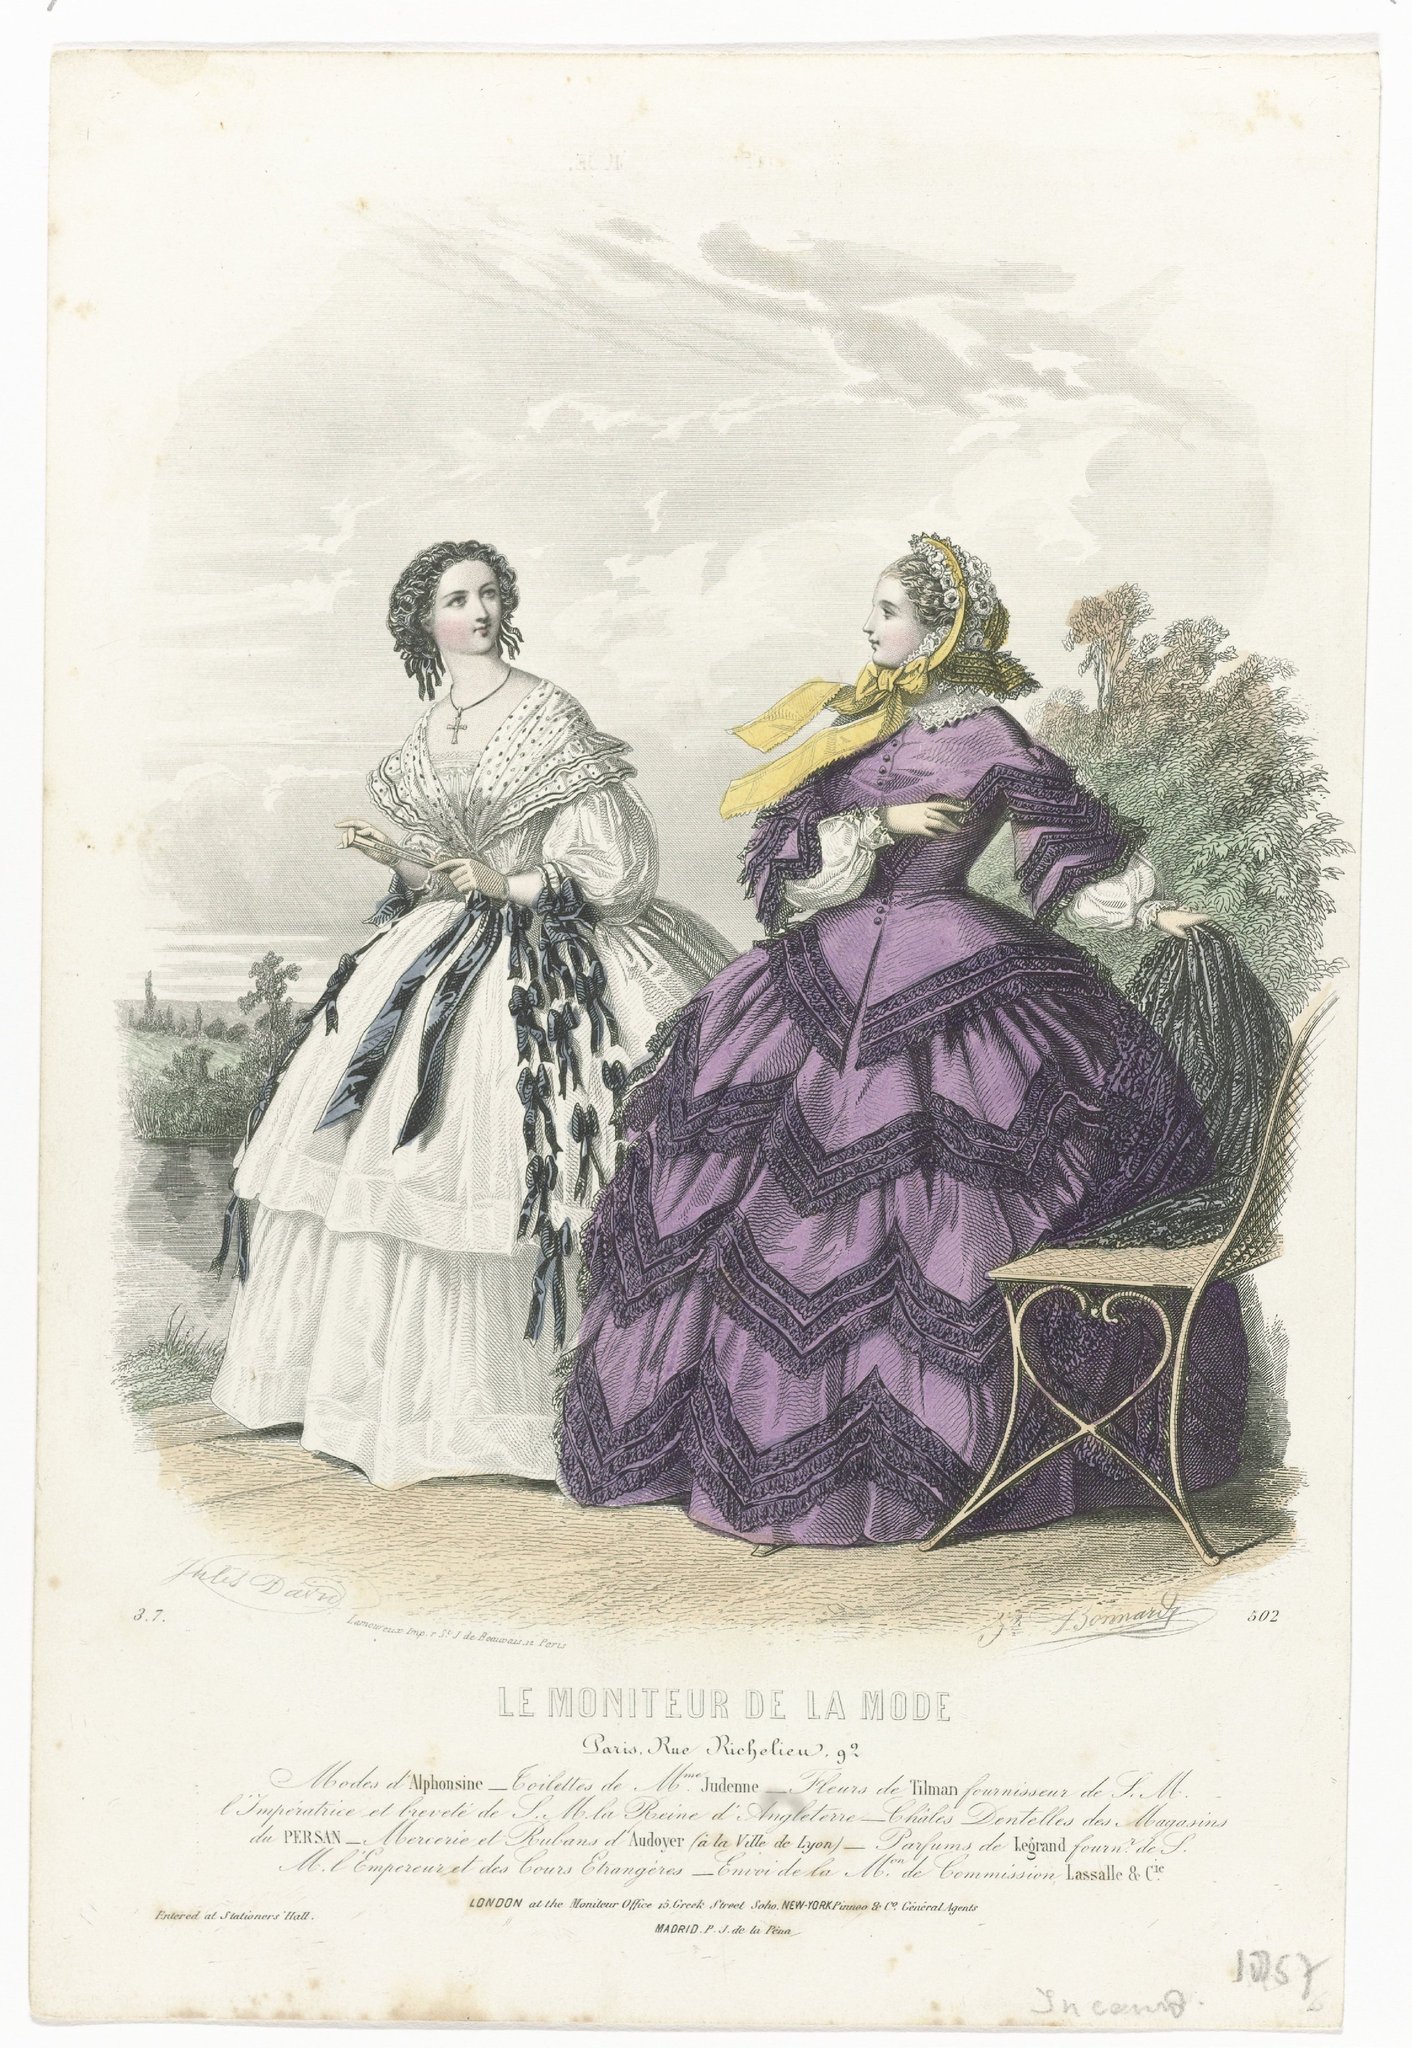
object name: fashion print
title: Le Moniteur de la Mode, 1857, No. 502 : Modes d'Alphonsin (...)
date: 1857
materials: paper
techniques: hand coloring, engraving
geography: paris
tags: flowers, pendant, trinket, 'breloque' (+ women's clothes), clothing for the upper part of the body (shawl) (+ women's clothes), ornamental parts of clothing (+ women's clothes), clothing for the upper part of the body (shawl) (+ lace used for clothes), fashion plates, head-gear: hat (+ women's clothes), gloves, mittens, etc. (+ women's clothes), fan (+ women's clothes)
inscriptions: caption: ‘Modes d'Alphonsine _ Toilettes de M.me Judenne _ Fleurs de Tilman fournisseur de S.M. L'Impératrice et breveté de S.M. la Reine d'Angleterre _ Châles Dentelles des Magasins du Persan _ Mercerie et Rubans d'Audoyer (à la Ville de Lyon) _ Parfums de Legrand fourn.r de S. M. L'Empereur et des Cours Etrangéres_ Envoi de la M.on de Commission Lassalle & Cie.’, address: ‘Paris, Rue de Richelieu, 92. / London at the Moniteur Office, 15, Greek Street Soho. New-York Pinneo & co. Général Agents / Madrid P.J. de la Péna’, title: ‘Le Moniteur de la Mode’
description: Twee vrouwen in een park. Volgens het onderschrift: 'modes' van Alphonsine. 'Toilettes' van Judenne. Hieronder enkele regels reclametekst voor verschillende producten. Prent uit het modetijdschrift Le Moniteur de la Mode (1843-1913).